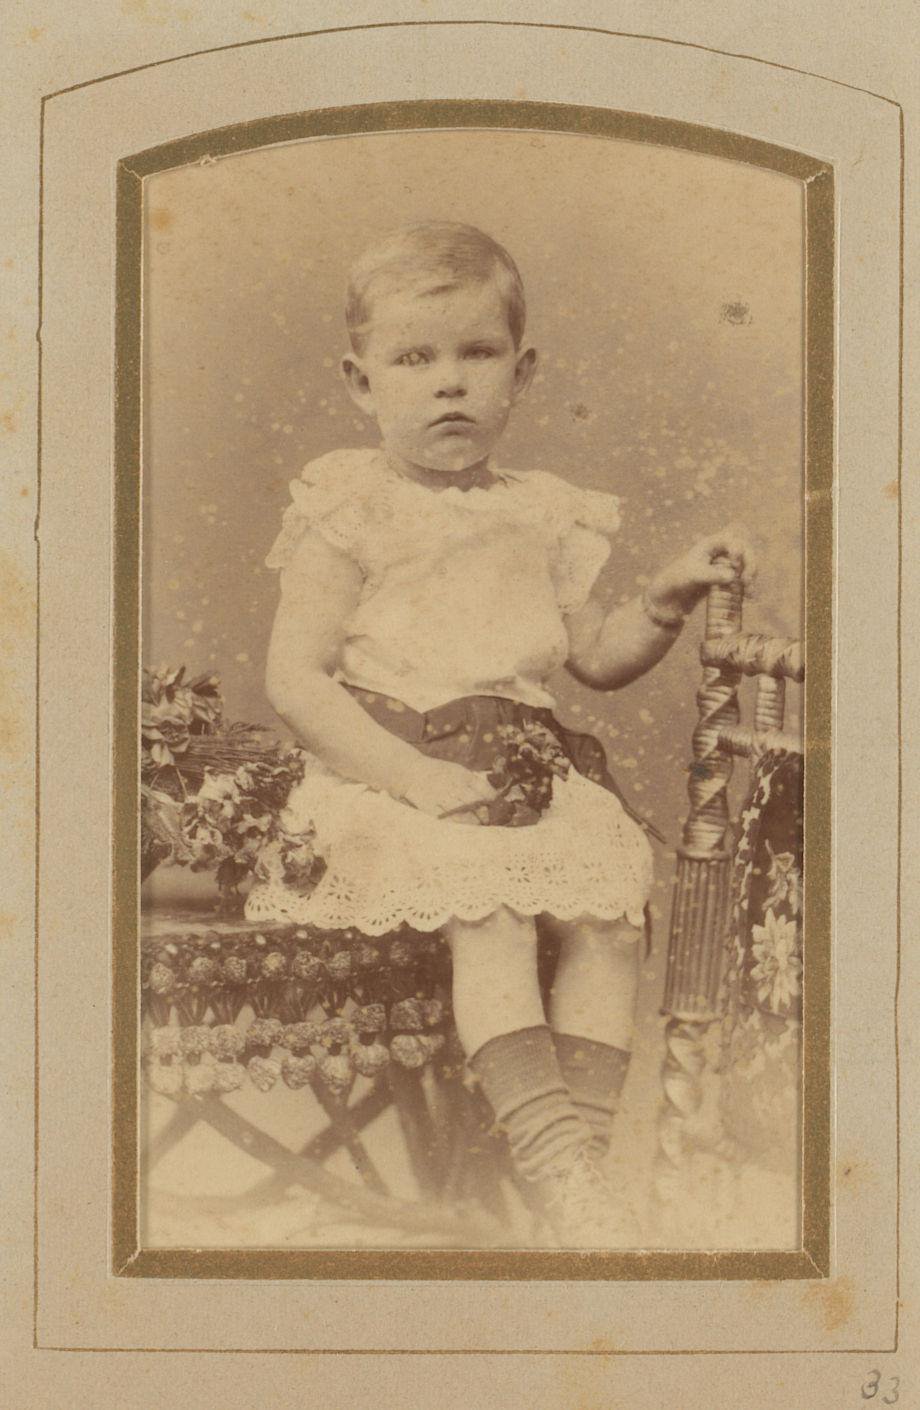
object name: photograph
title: Studioportret van Margo Kessler op jeugdige leeftijd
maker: kameke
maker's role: painter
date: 1887-1892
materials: paper, photographic support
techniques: photography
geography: the hague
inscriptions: inscription: ‘Go Kessler’